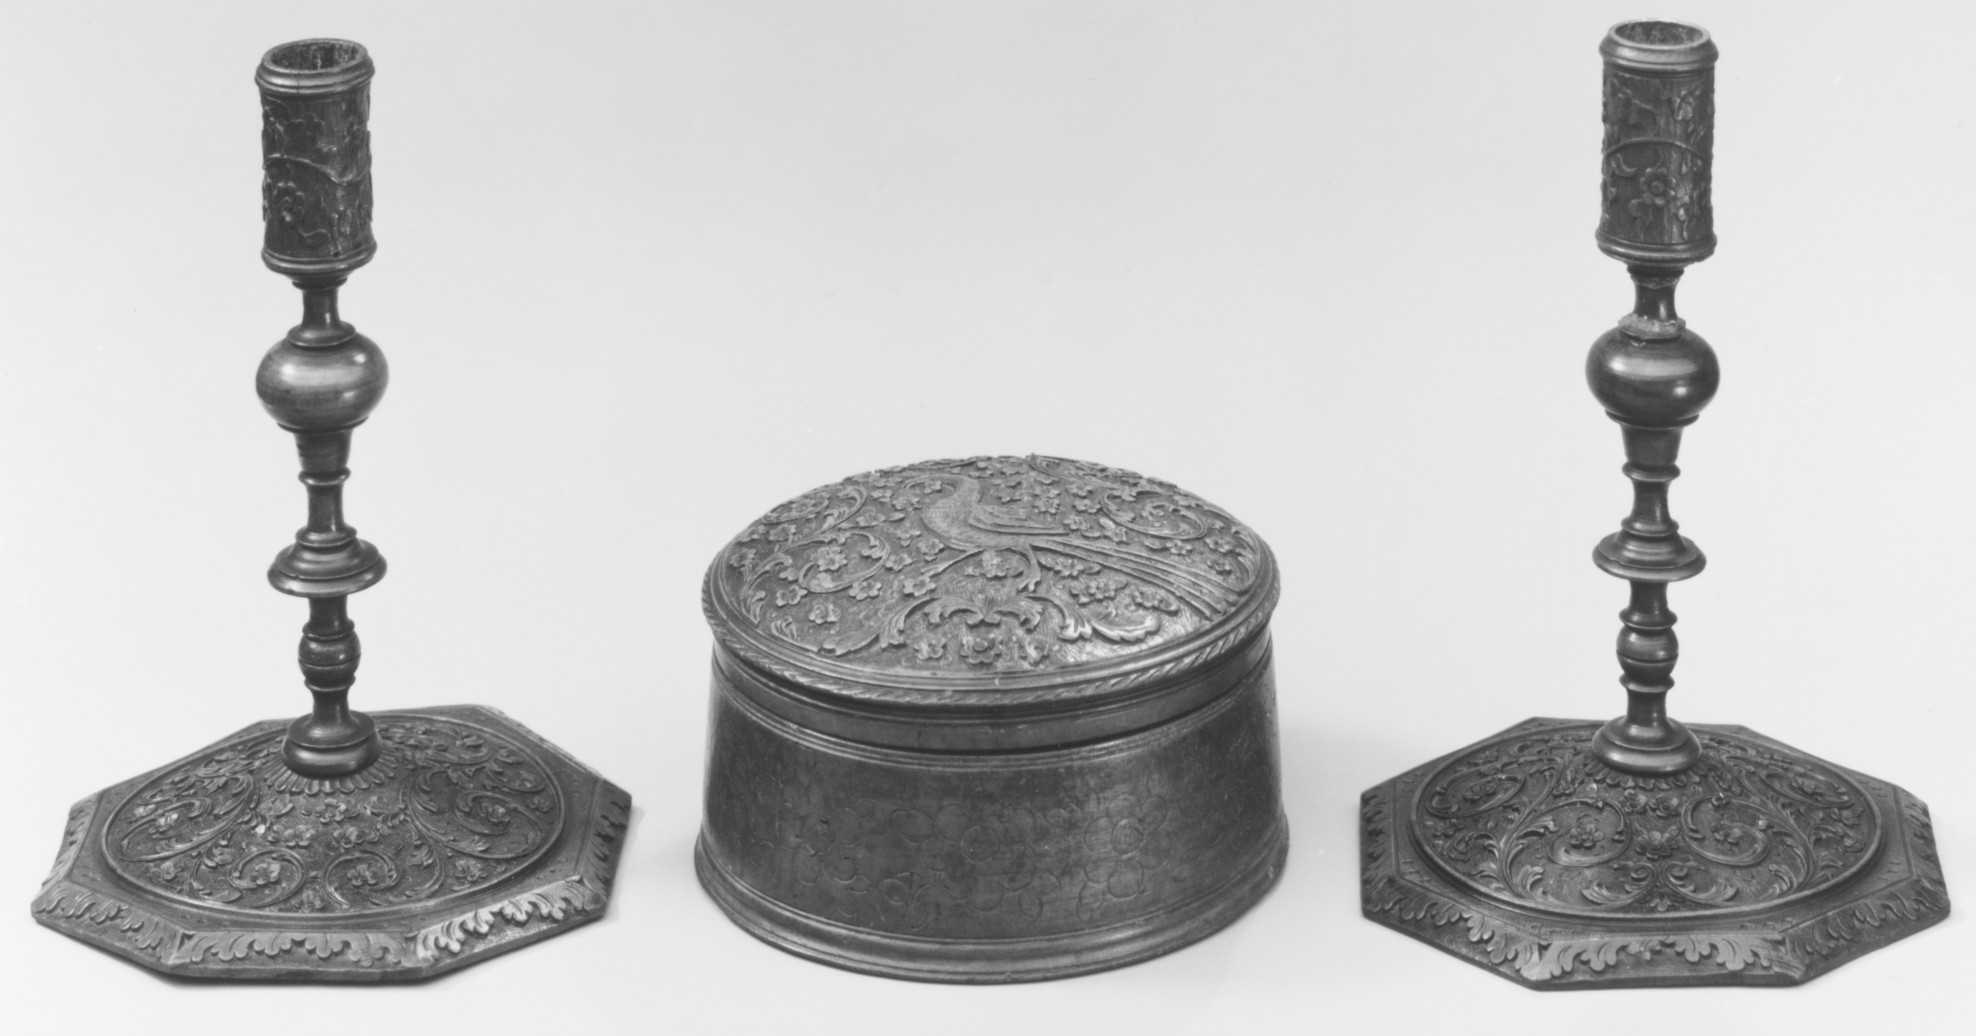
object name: box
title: Box (part of a set)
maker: nicolas françois foulon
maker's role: maker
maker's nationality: french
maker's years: 1628-1698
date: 1667-1733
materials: wood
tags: birds